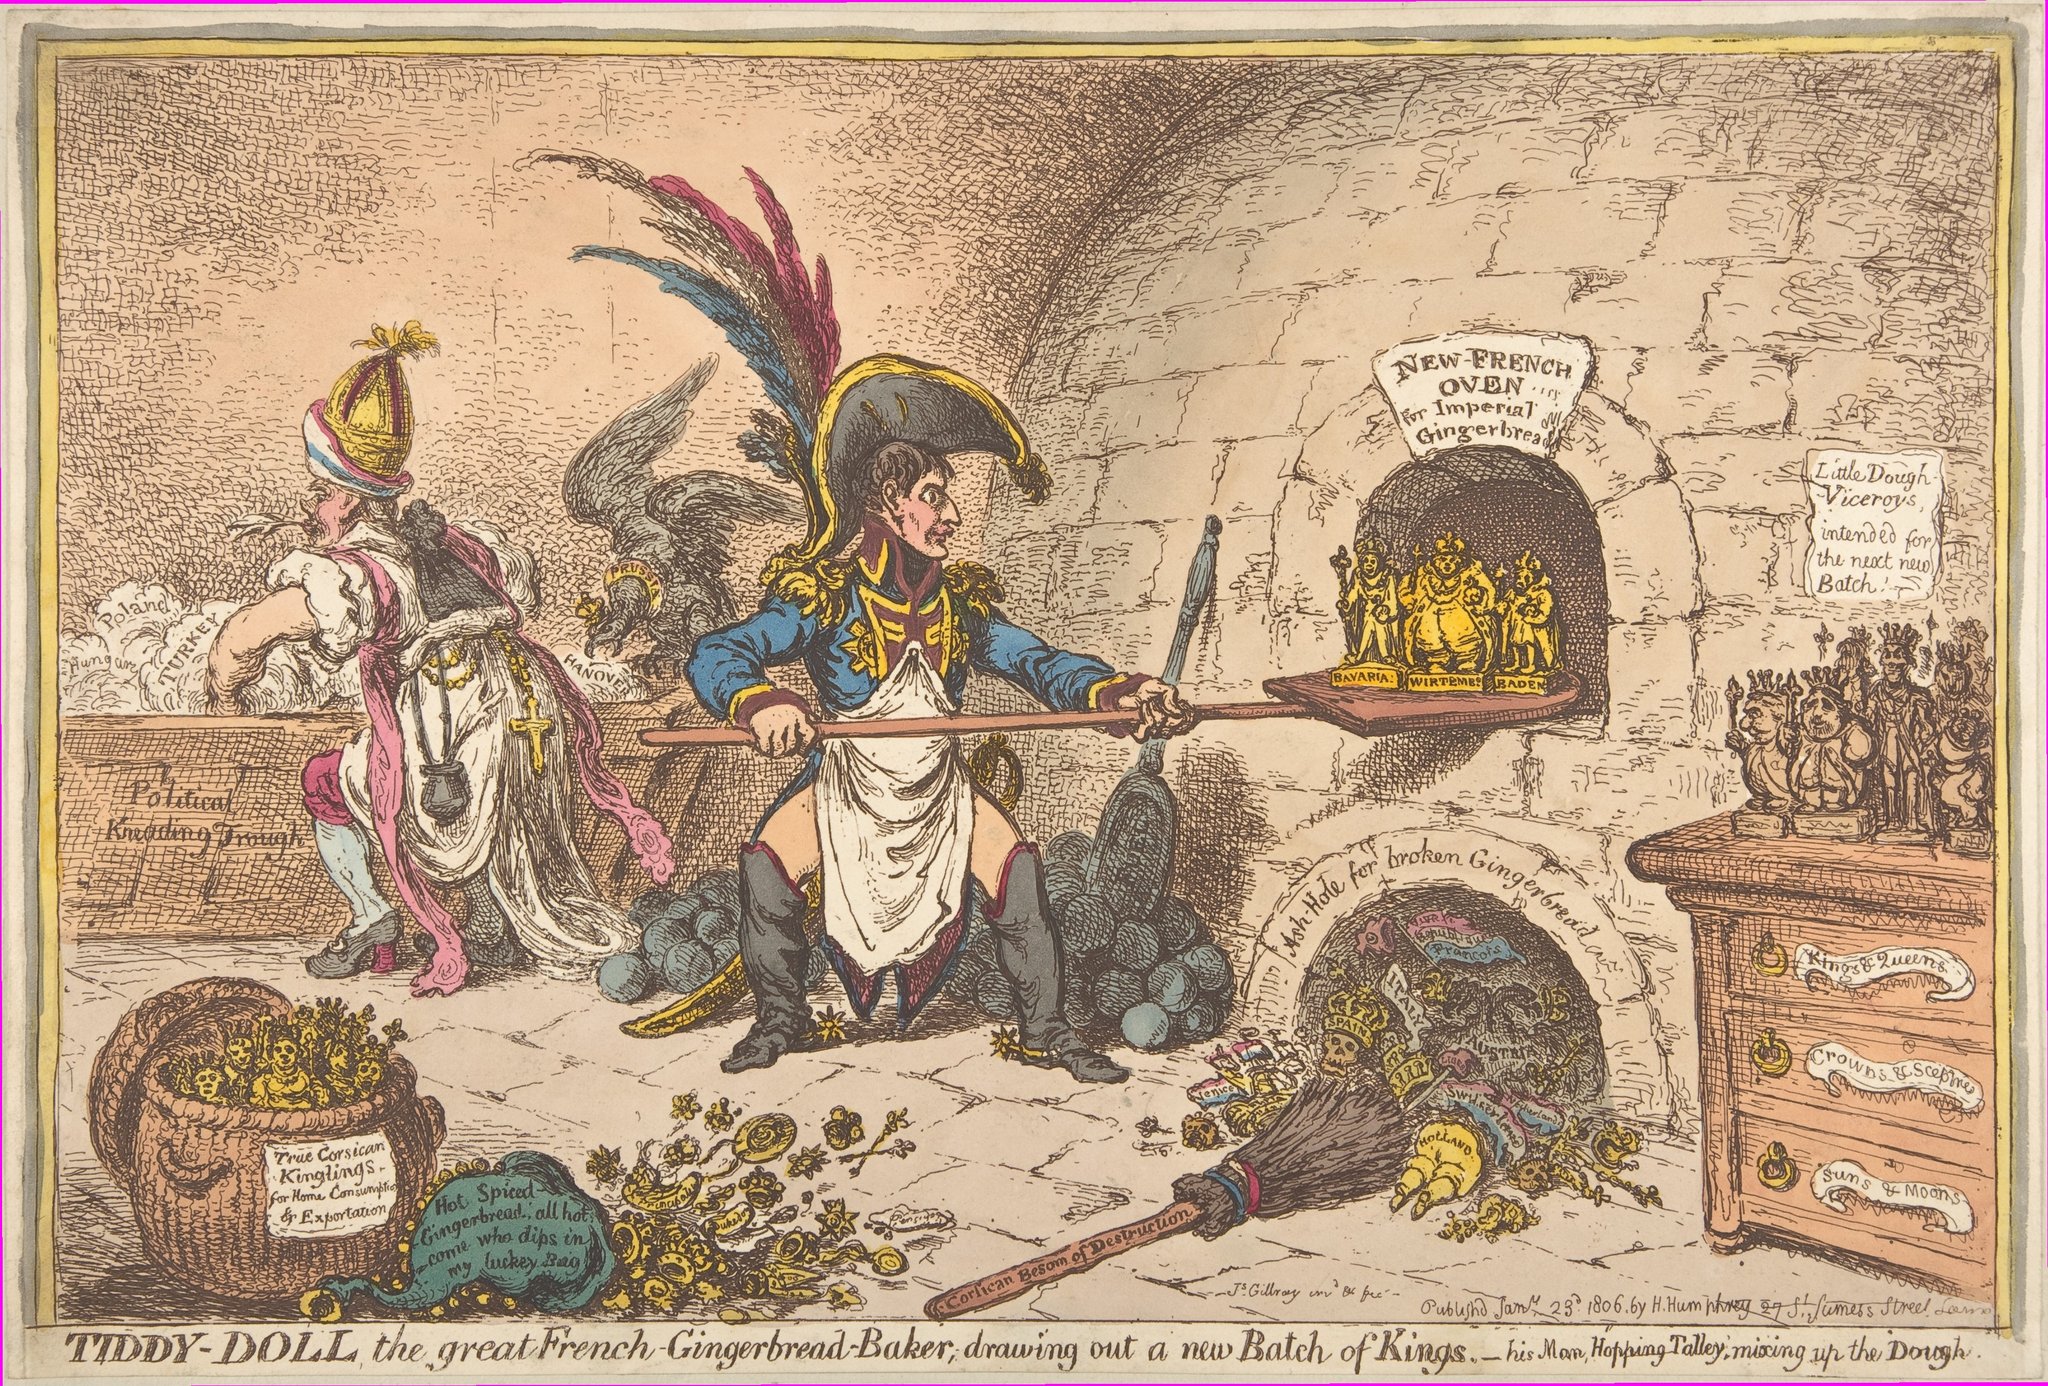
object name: print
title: Tiddy-Doll, the Great French-Gingerbread-Baker; Drawing Out a New Batch of Kings, His Man Hopping Talley, Mixing Up the Dough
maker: james gillray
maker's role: artist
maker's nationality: british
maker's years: 1756-1815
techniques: etching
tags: satire,napoleon i,men,politics